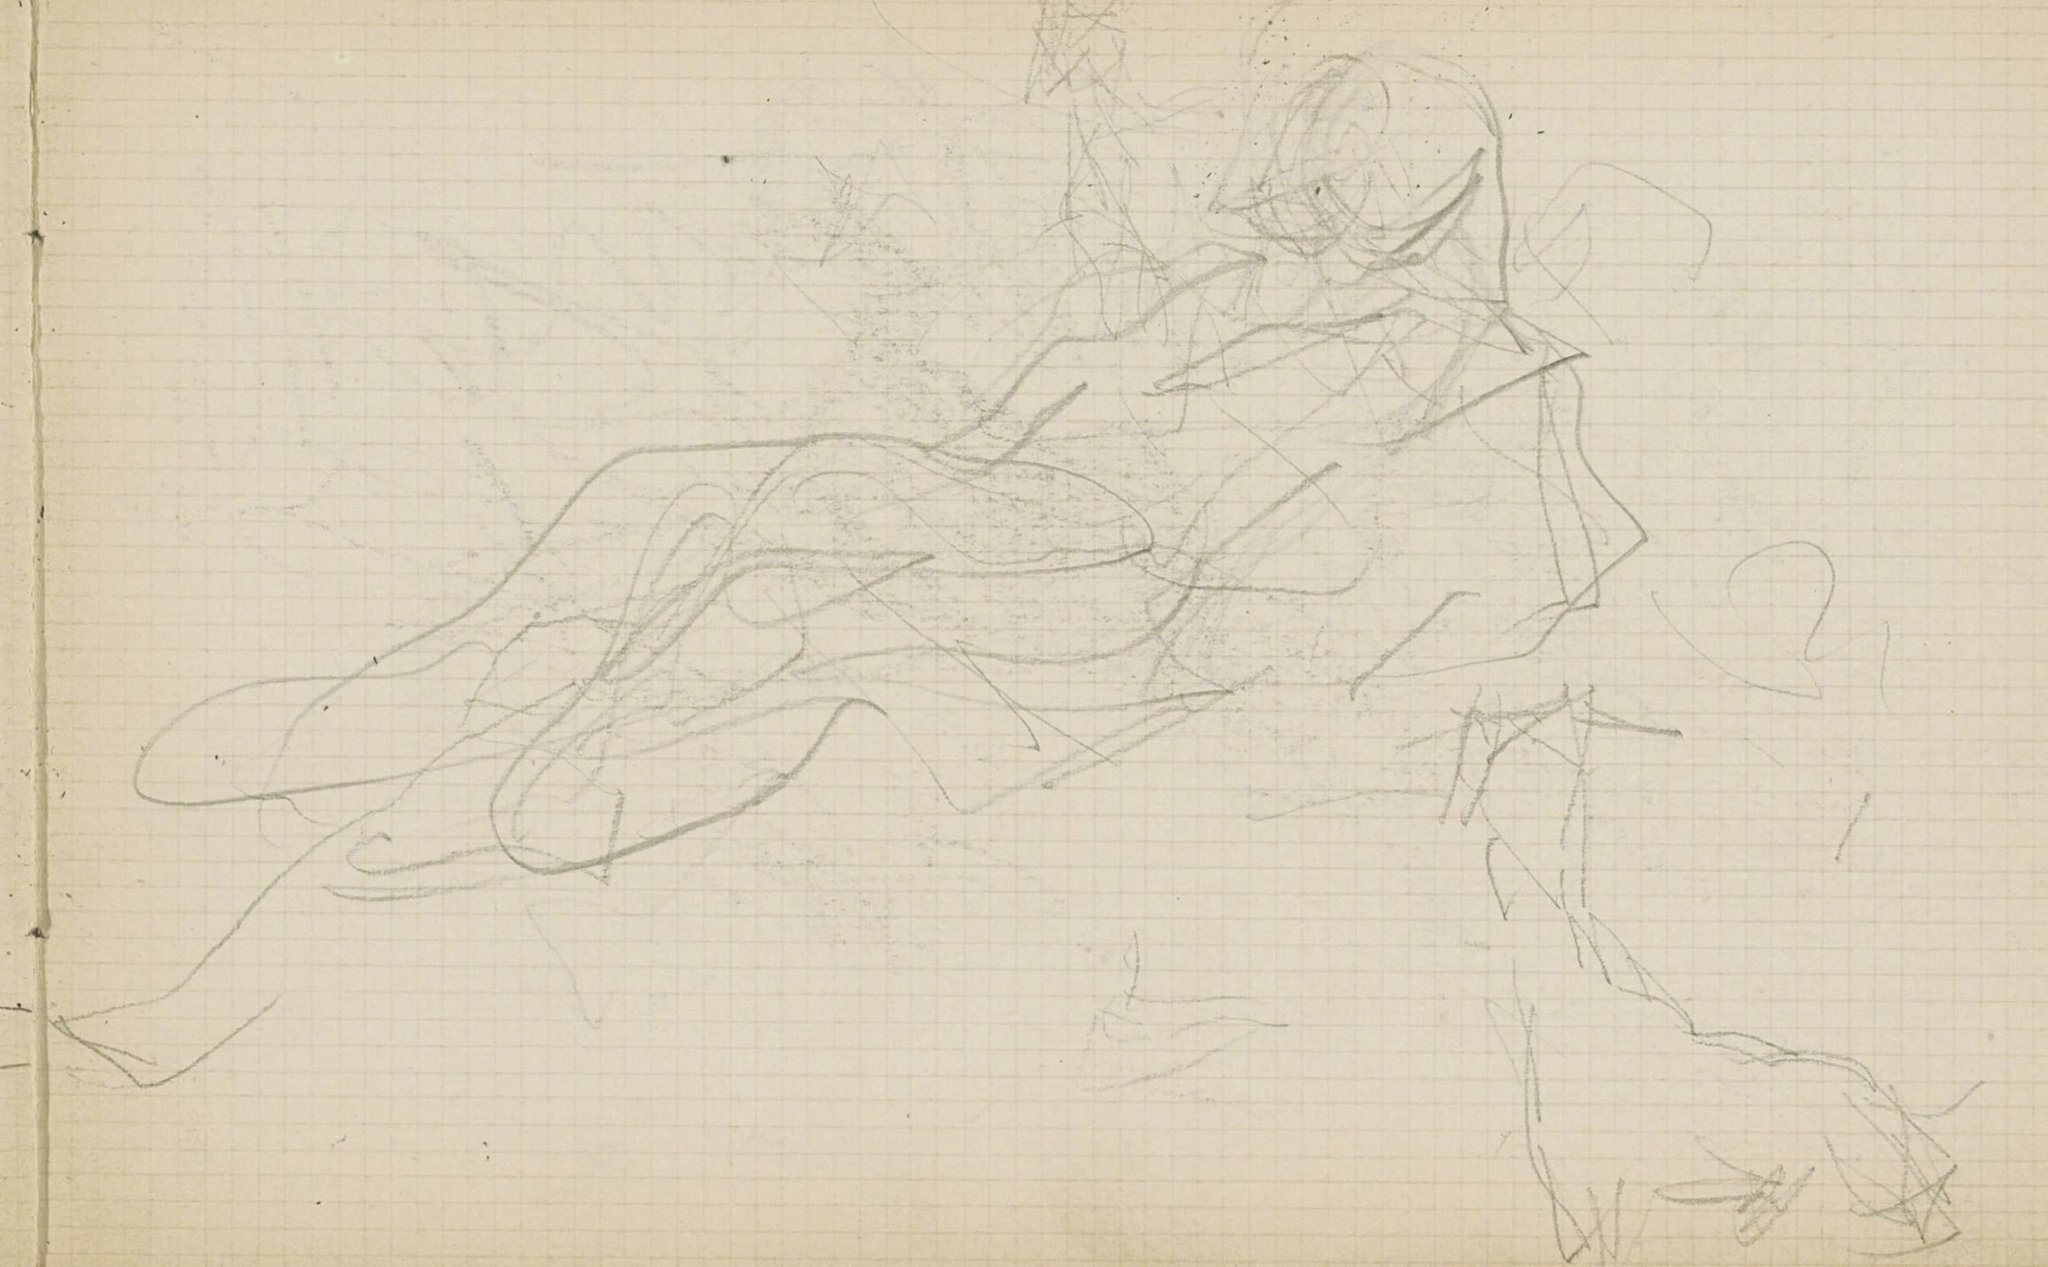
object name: sketchbook leaf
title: Liggende figuur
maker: matthijs maris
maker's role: draughtsman, painter, print maker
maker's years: 1839-1917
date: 1849-1917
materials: pencil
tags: lying figure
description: Blad 24 recto uit een schetsboek met 35 bladen.